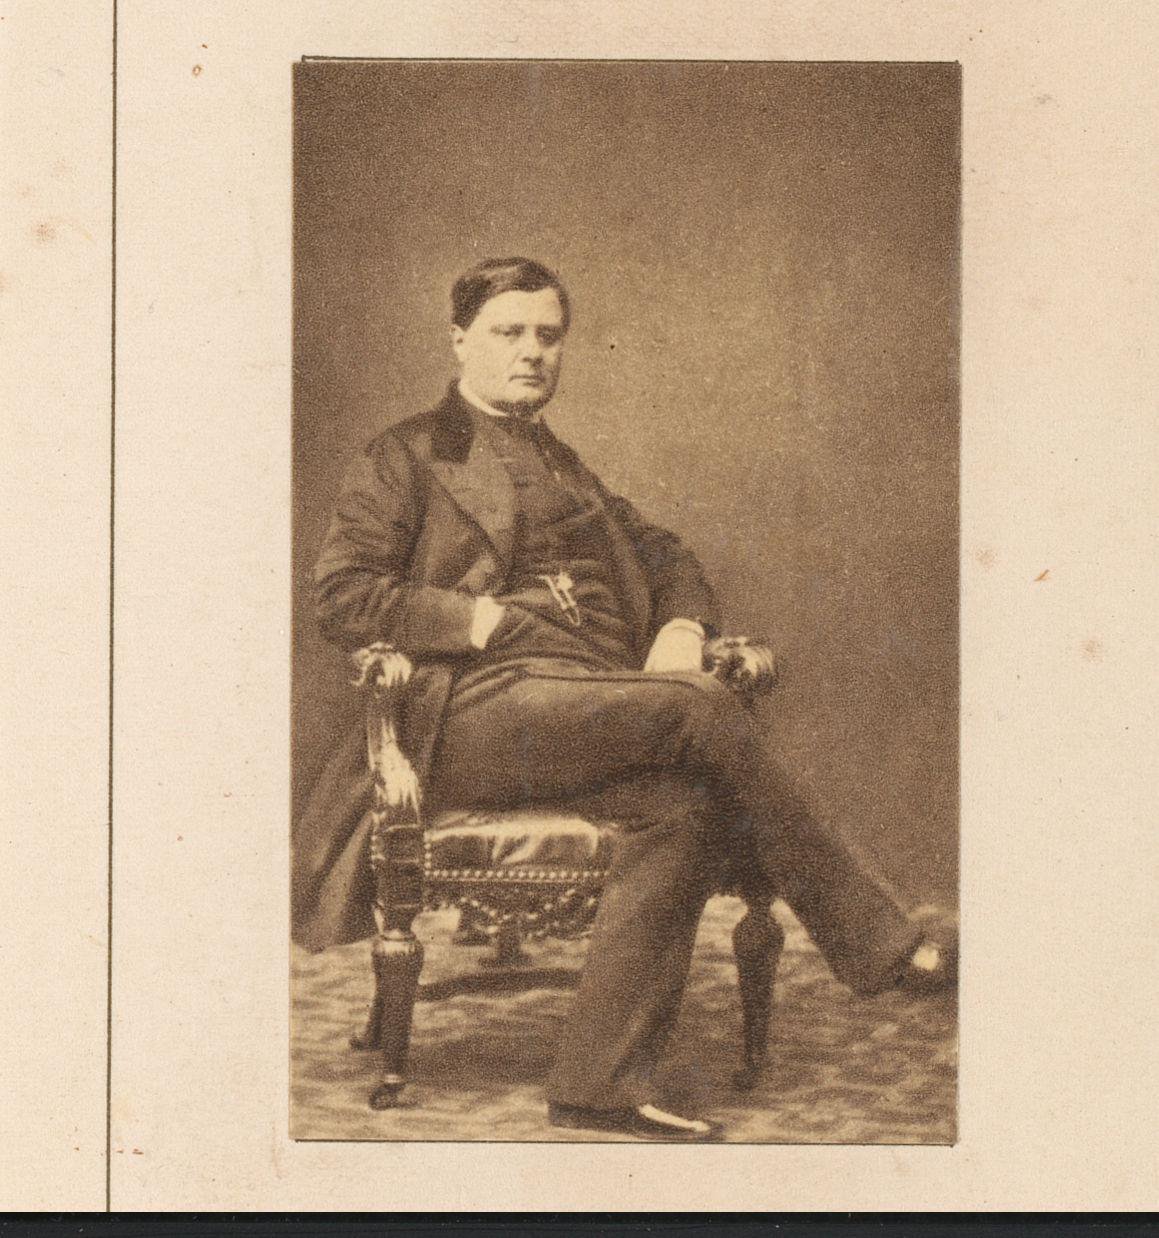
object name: album leaf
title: Portret van Alexandre Colonna-Walewski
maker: Anonymous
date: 1854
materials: paper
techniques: rotogravure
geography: france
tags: historical persons, diplomacy, diplomat, france